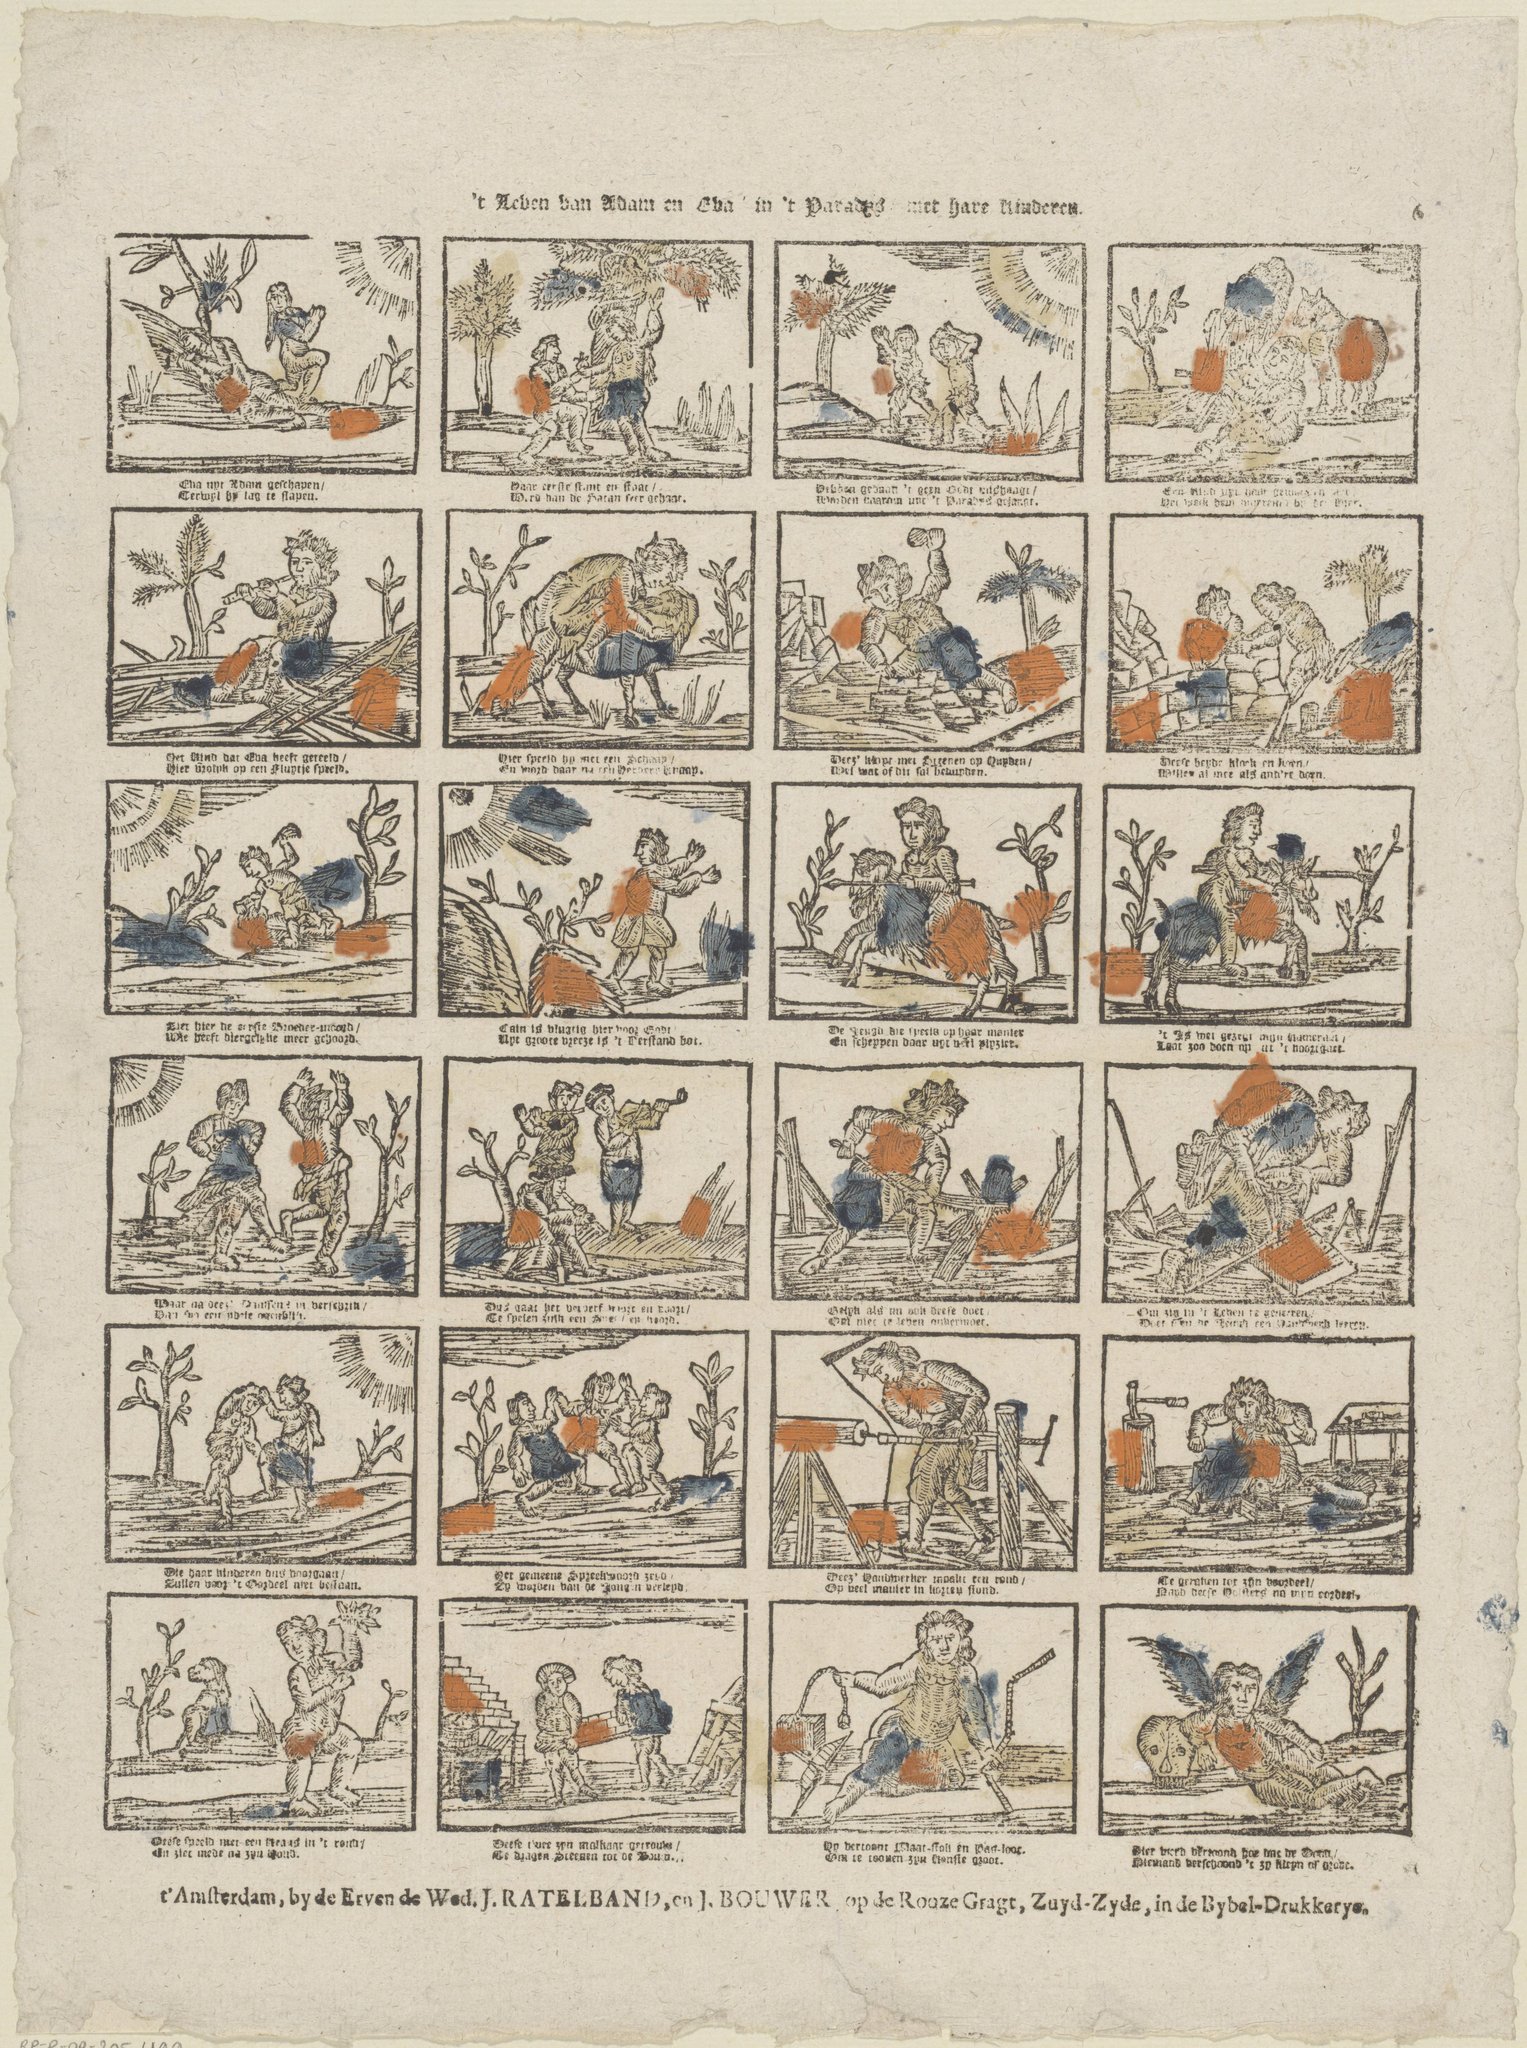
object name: print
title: 't Leven van Adam en Eva / in 't paradys / met hare kinderen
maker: Anonymous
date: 1782-1793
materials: paper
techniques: colour, letterpress printing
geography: amsterdam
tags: craft-production, skilled handiwork, expulsion of adam and eve from paradise (genesis 3:22-24), old testament, crafts and industries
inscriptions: collector's mark: Lugt 2760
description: Blad met 24 voorstellingen van verhalen uit het Oude Testament en voorstellingen van ambachten en bezigheden. Onder elke afbeelding een tweeregelig vers. Genummerd rechtsboven: 6.